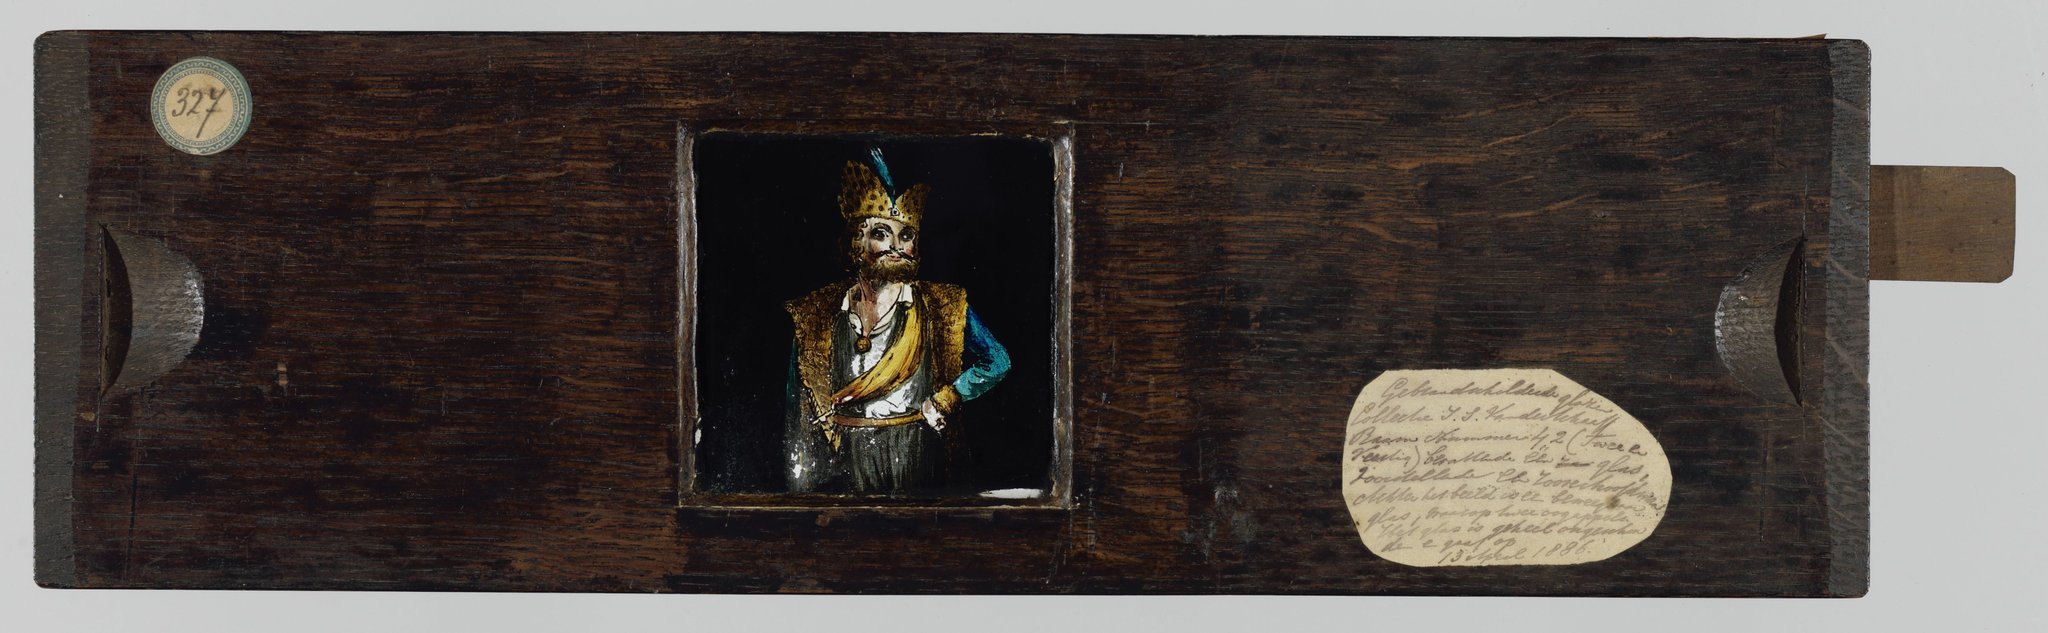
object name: lantern slide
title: Beweegbare plaat van een roverhoofdman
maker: Anonymous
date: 1790-1830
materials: glass, wood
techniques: painted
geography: france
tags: robber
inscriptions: label: ‘'Gebrandschilderde glazen. Collectie I.S. van der Schaaff, Baarn. Nummer 42 (tweeënveertig) bevattende één glas, voorstellende een roovershoofdman. Achter het glas is beweegbaar glas, waarop twee oogappels zichtbaar zijn. Het glas is geheel ongeschonden en gaaf op 13 april 1886.'’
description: Vierkante glasplaat in houten vatting. Roverhoofdman te halven lijve, met baard en hoofddeksel, gekleed in geel en blauw. De pupillen van de ogen zijn op een aparte glasplaat geschilderd en kunnen met een schuifje bewogen worden.